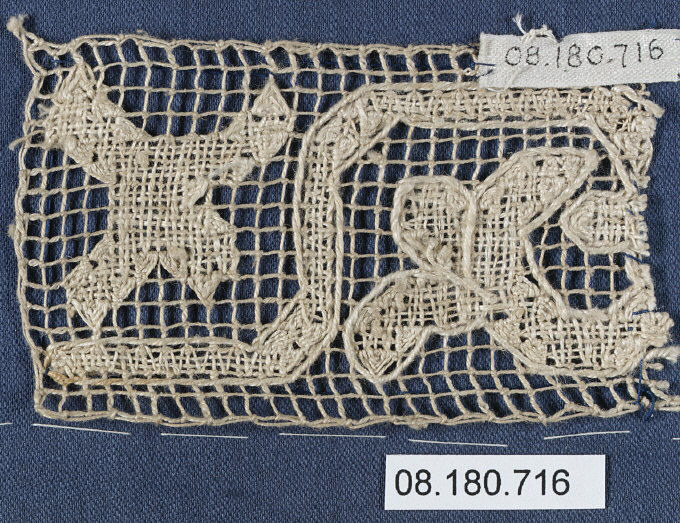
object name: insertion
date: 1801-1900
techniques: embroidery